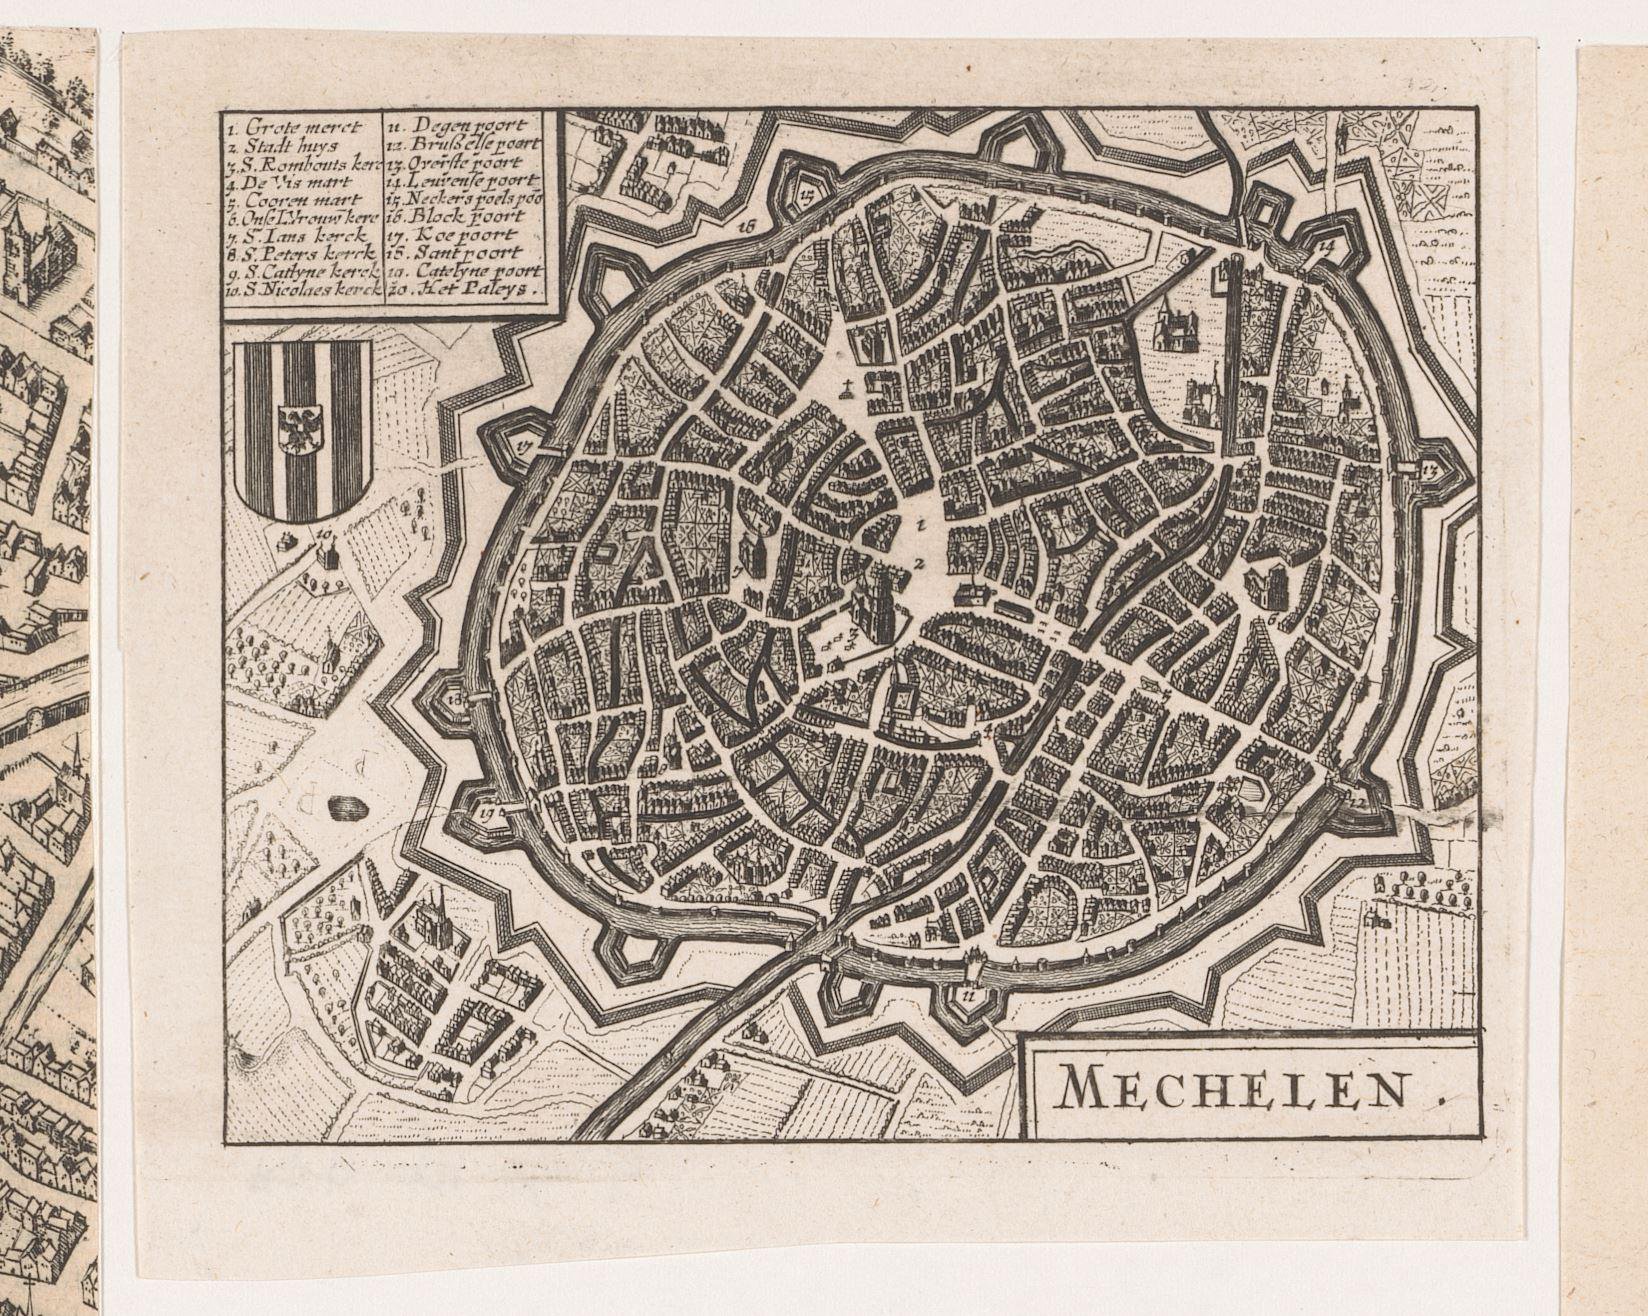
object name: area plan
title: Malines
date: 1649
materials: ink, paper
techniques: etching, writing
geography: amsterdam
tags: maps of cities, mechelen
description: Deze prent is waarschijnlijk een proefdruk voor de plattegrond die Blaeu uitgaf in het Stedenboeck, zoals beschreven door Koeman. In deze proefdruk is de titel met de hand in het lege vlak rechtsonder geschreven (waar in de uiteindelijke prent de titelcartouche gedrukt is). Tevens lege ruimte waar de twee wapens, links- en rechtsboven, zouden komen.